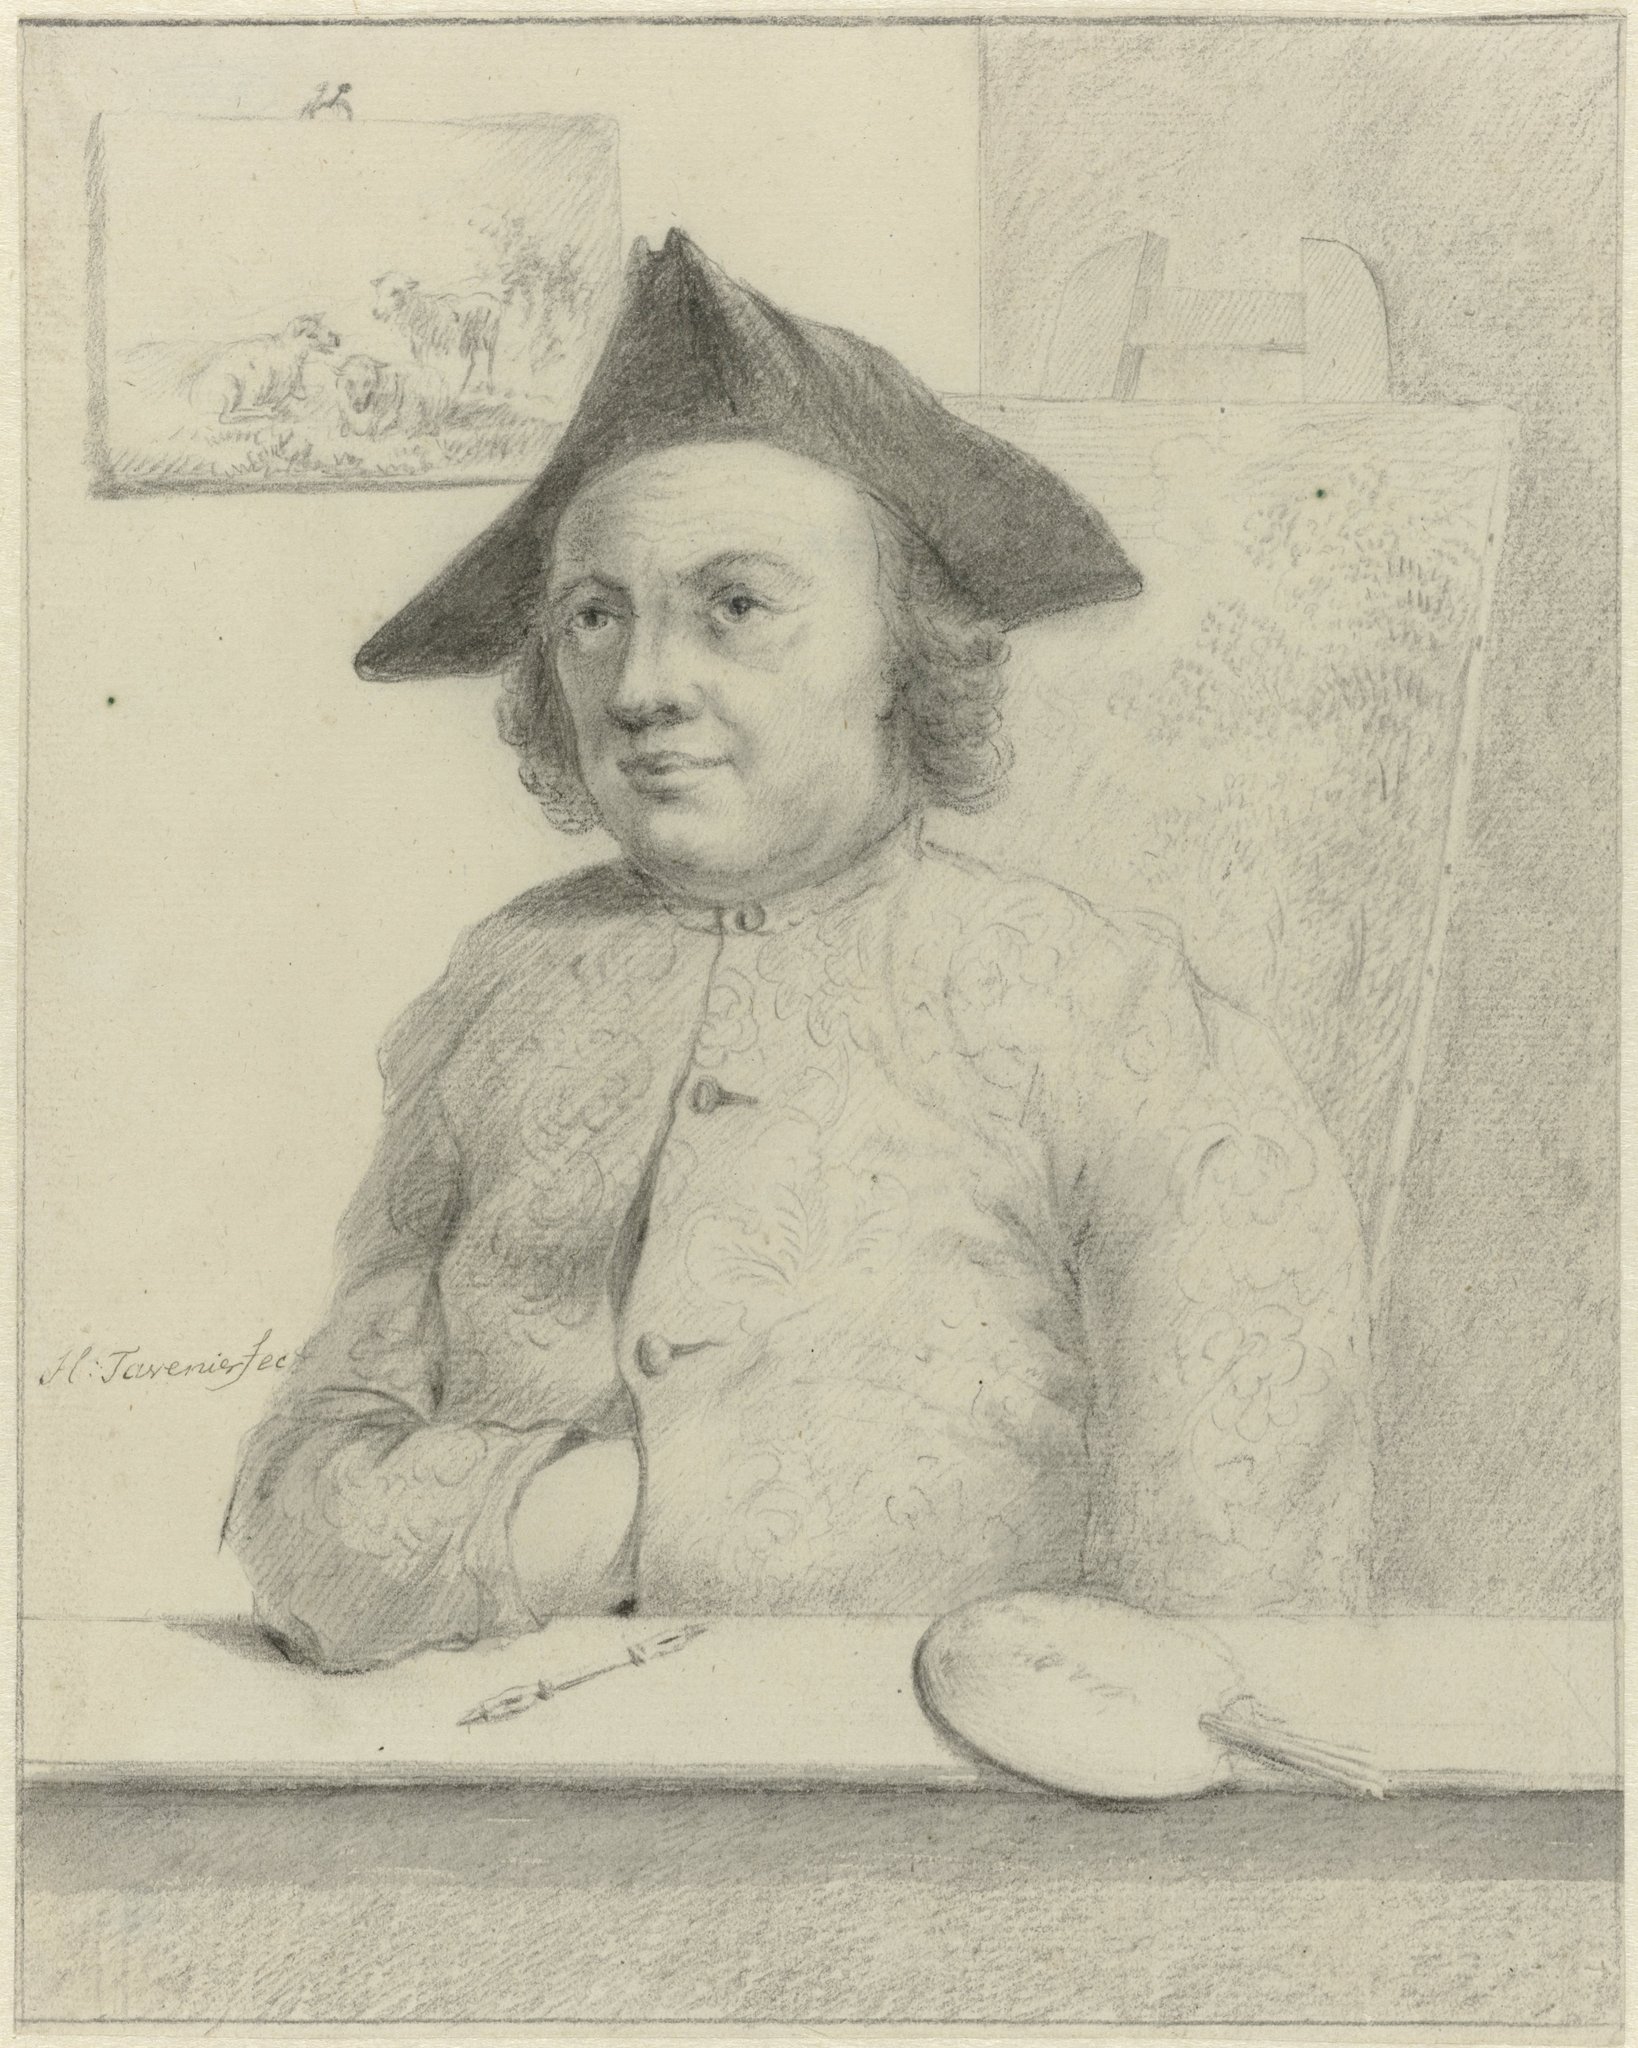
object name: drawing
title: Zelfportret van Hendrik Tavenier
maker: hendrik tavenier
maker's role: draughtsman, print maker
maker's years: 1734-1807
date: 1744-1807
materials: chalk, paper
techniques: brush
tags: haarlem, print maker, draughtsman, hendrik tavenier, historical persons, portrait, self-portrait of painter, portrait, self-portrait of artist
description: Zelfportret van de schilder Hendrik Tavenier.